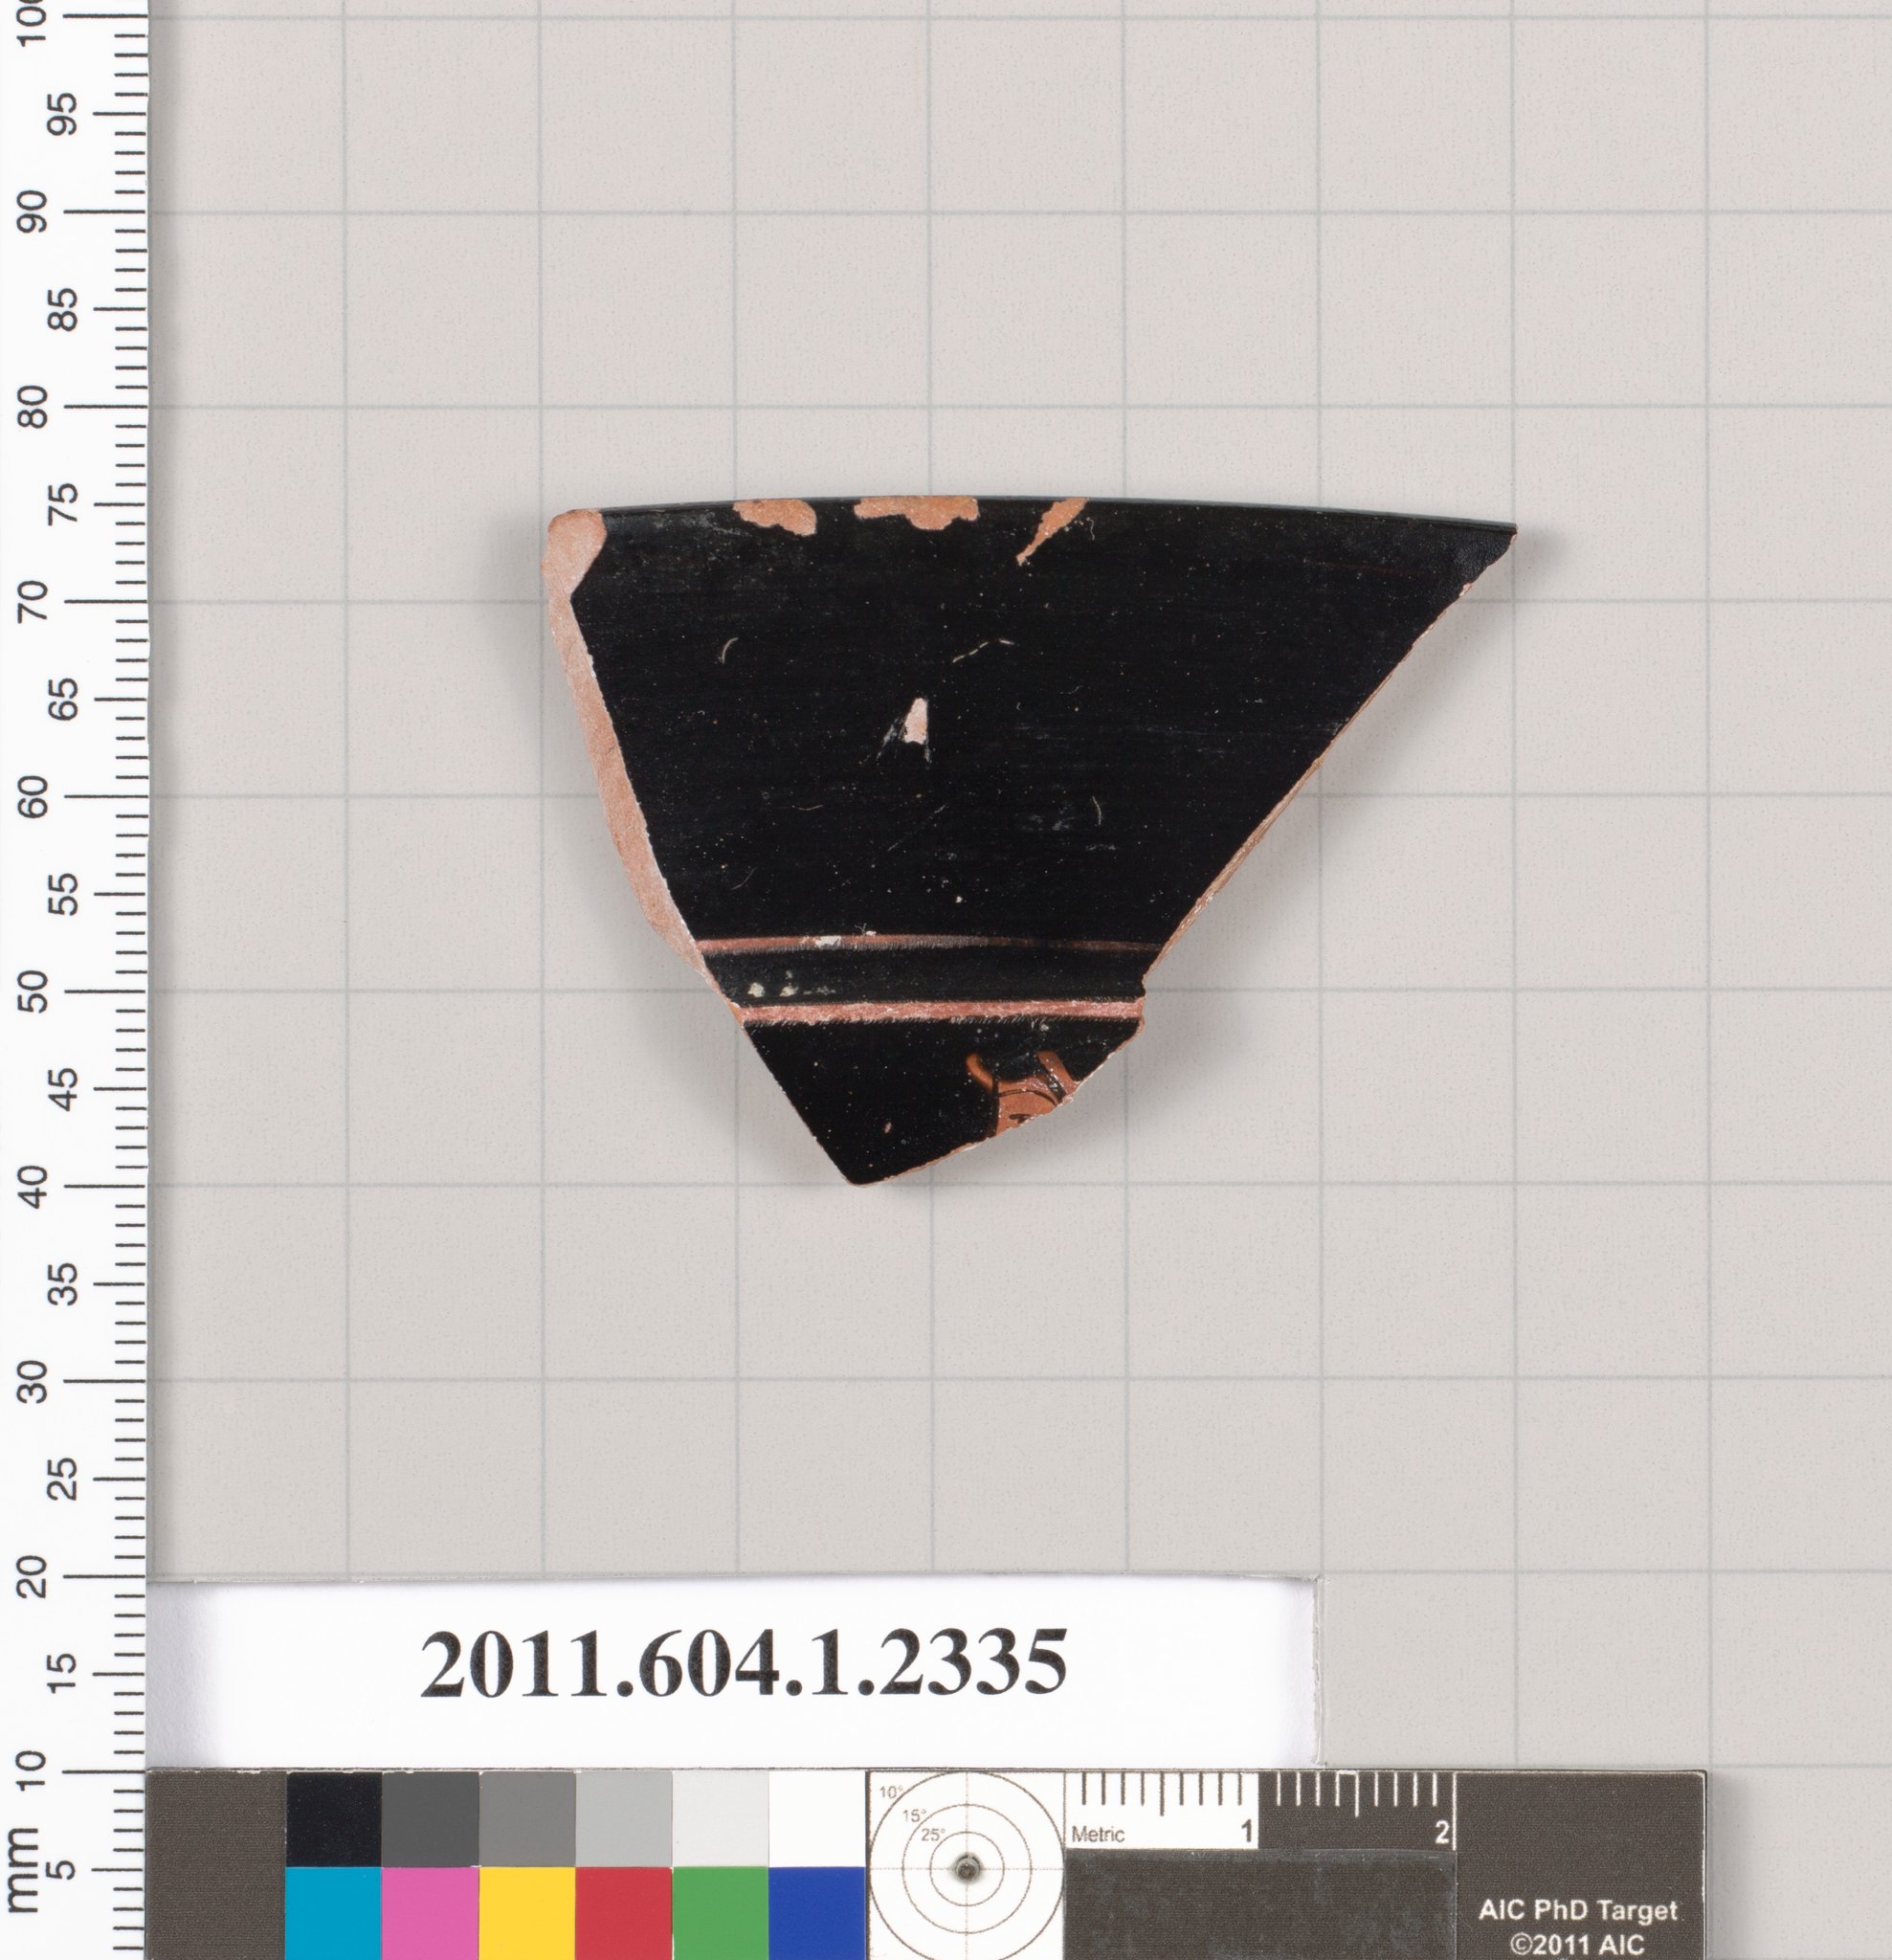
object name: kylix fragment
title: Terracotta rim fragment of a kylix (drinking cup)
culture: greek, attic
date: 475-451 BCE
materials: terracotta